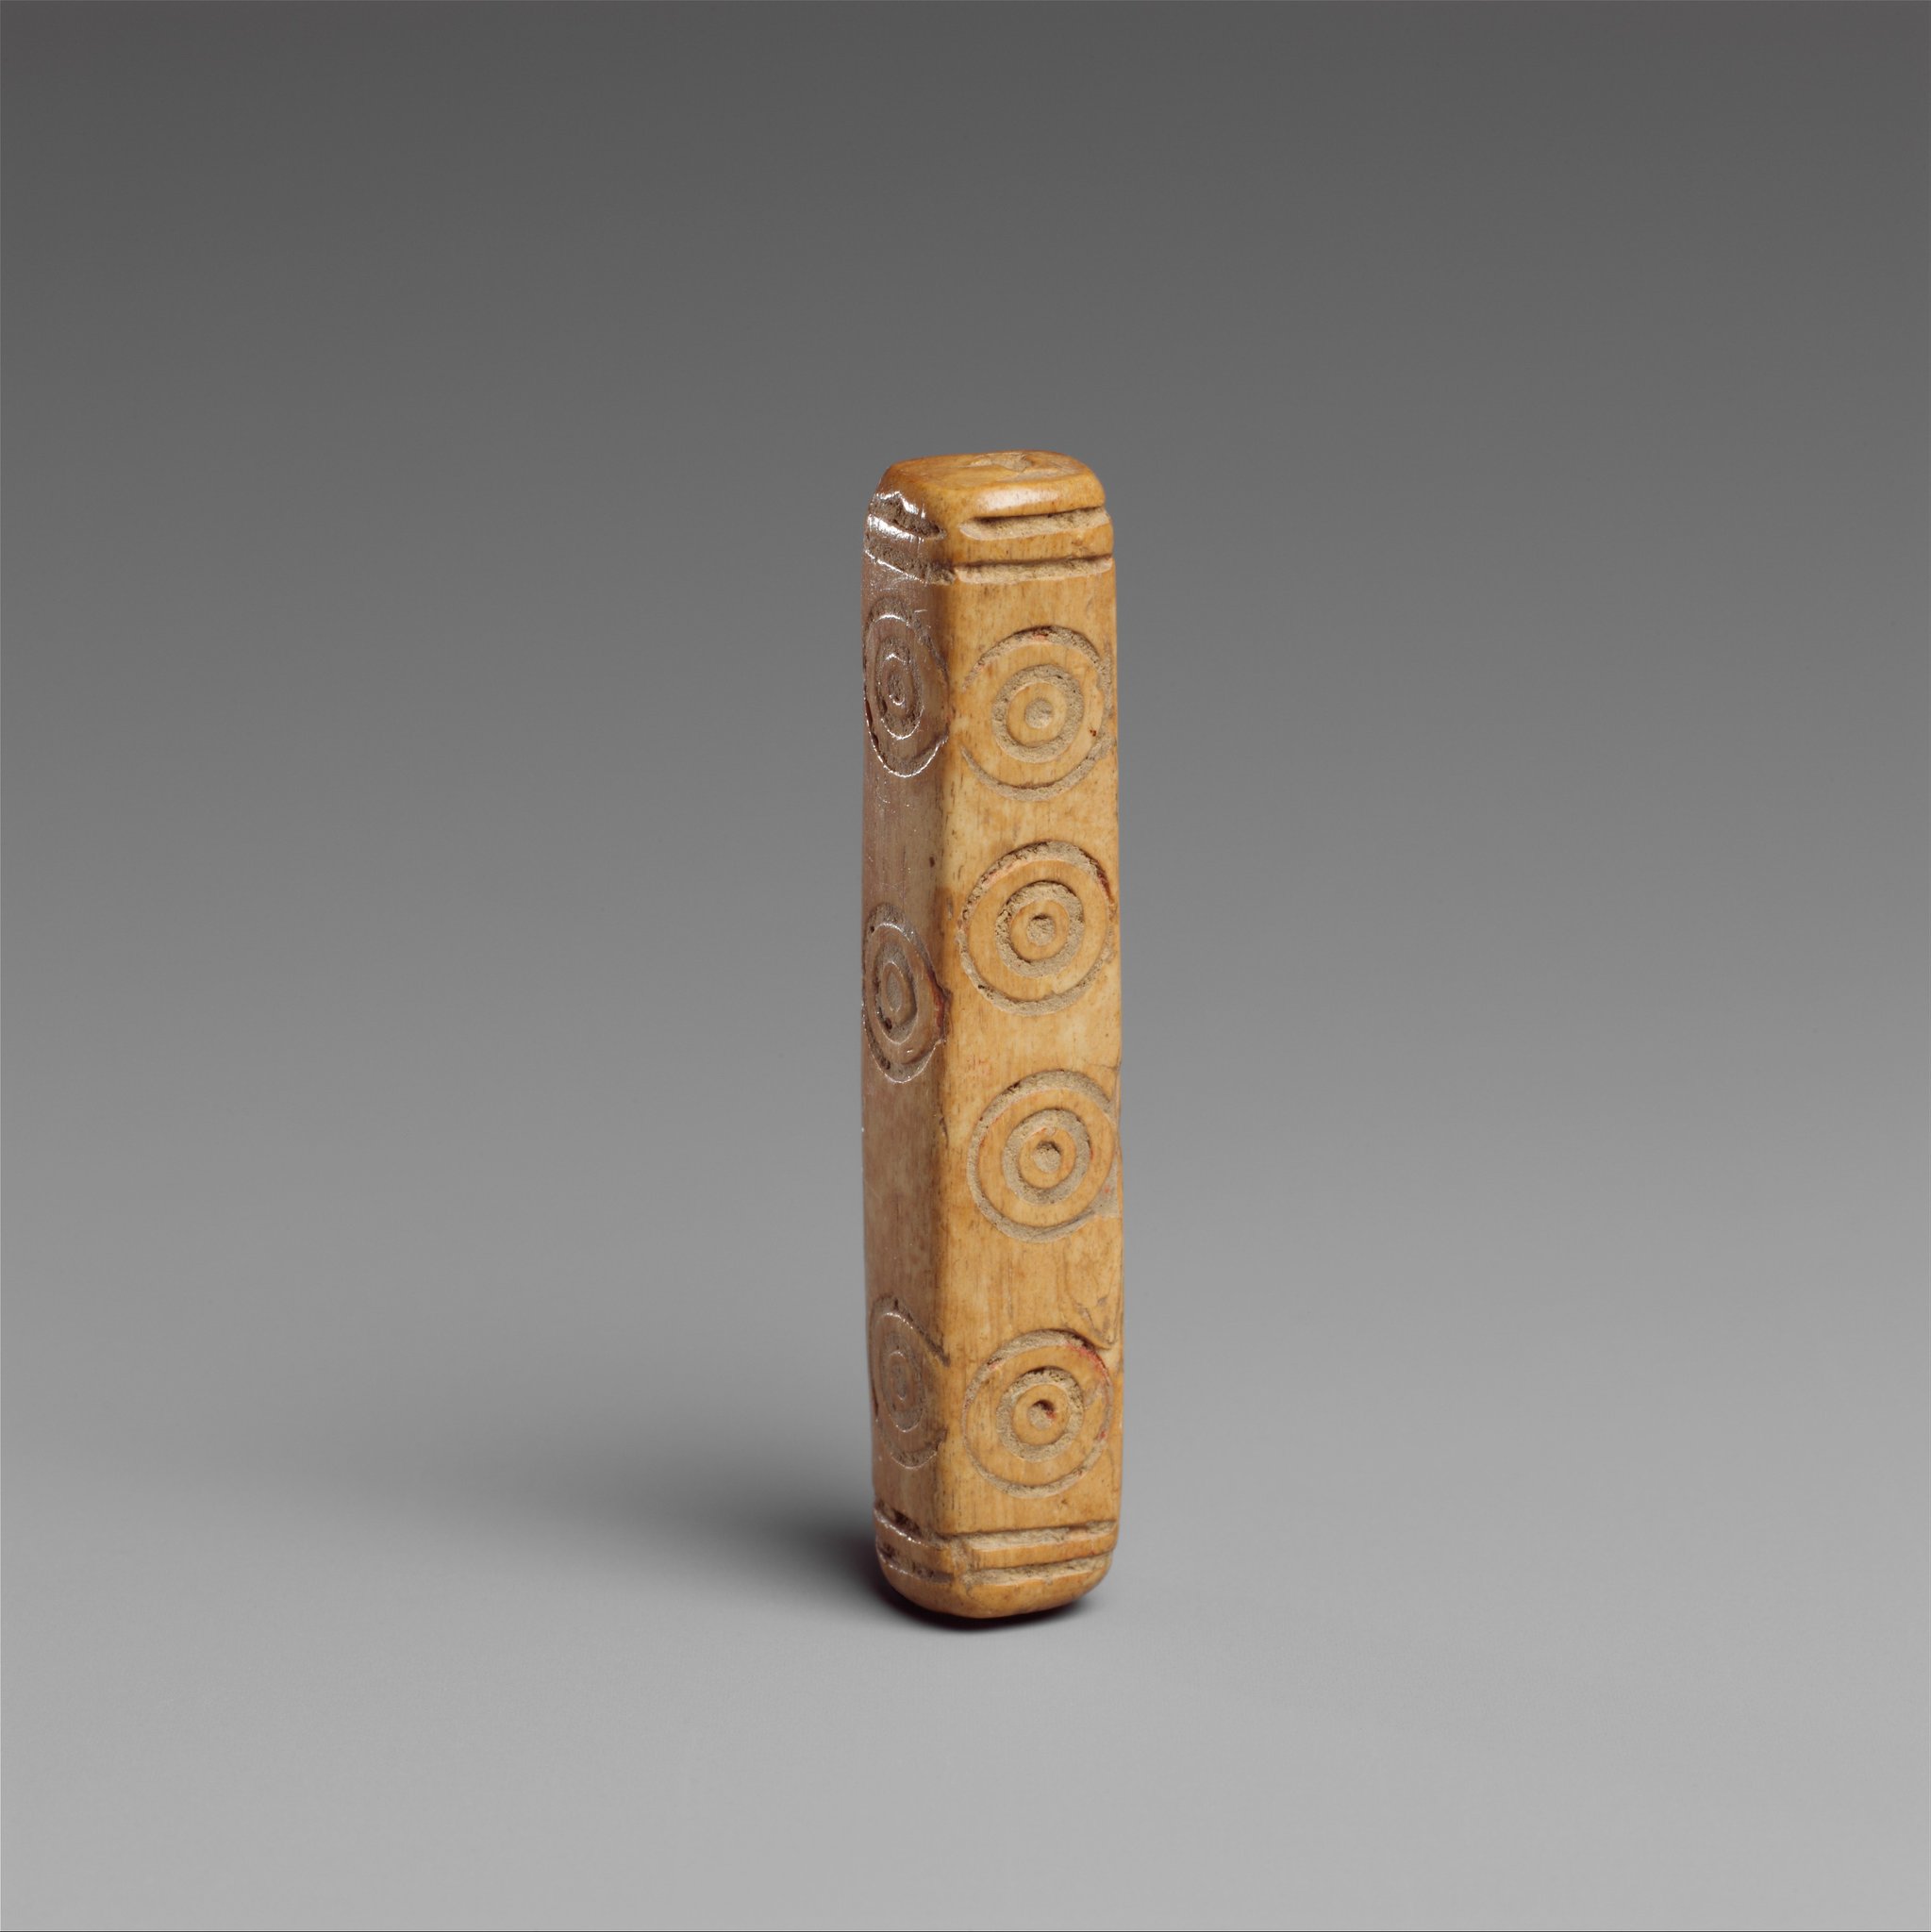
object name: dice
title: Gaming Die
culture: afghanistan or gandhara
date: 1-300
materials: ivory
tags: satavahana